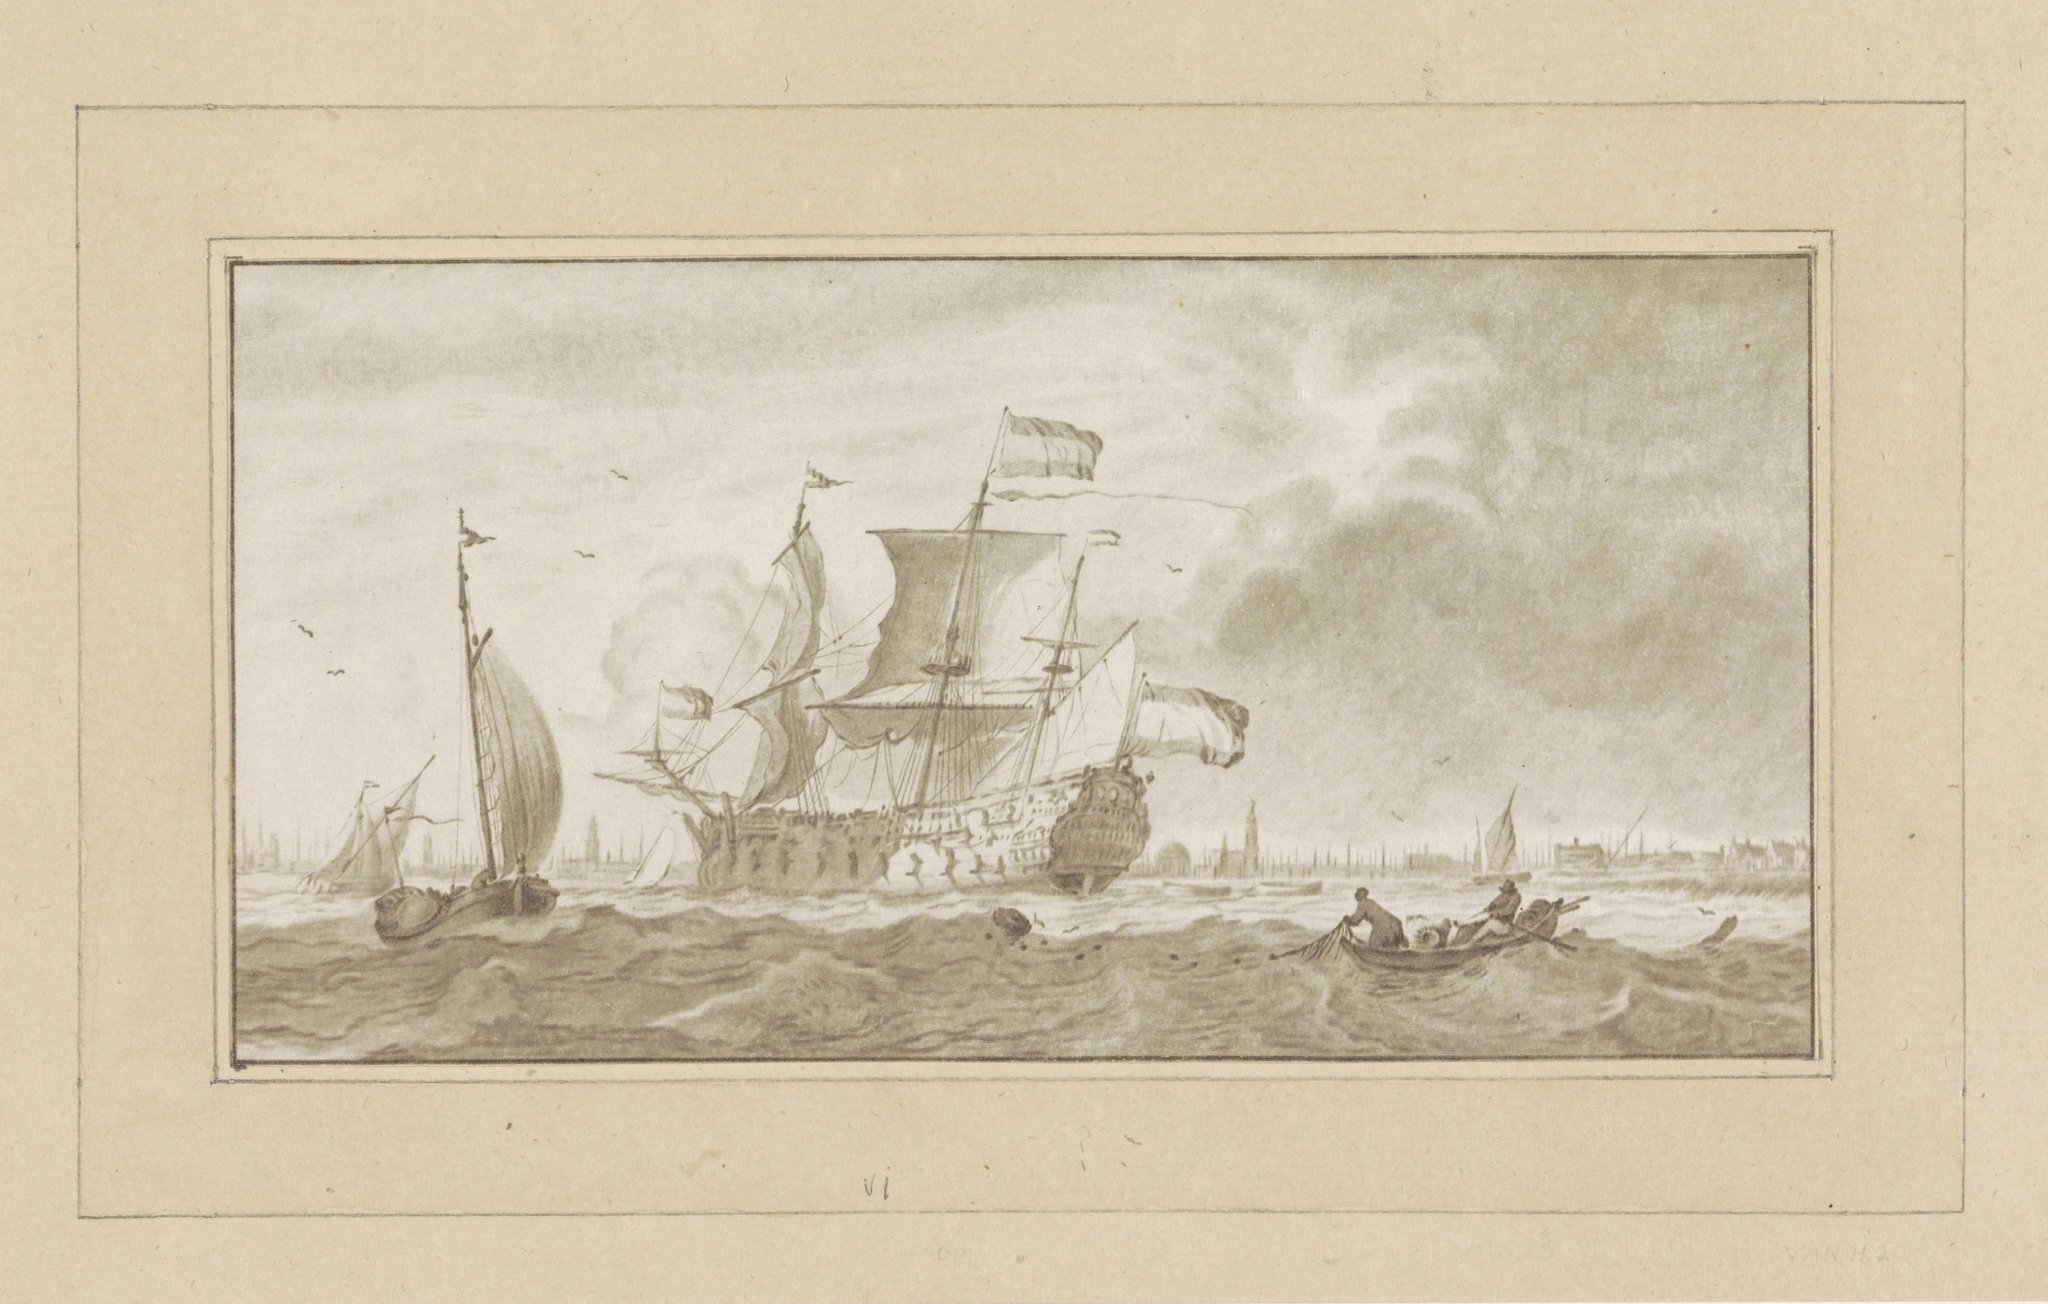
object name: print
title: Oorlogsschip op het IJ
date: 1768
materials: paper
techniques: etching, roulette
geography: amsterdam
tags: sailing-ship, sailing-boat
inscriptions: collector's mark: Lugt 2228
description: Een oorlogsschip op het IJ voor Amsterdam. Links een zeil schip, rechts een roeiboot met vissers.